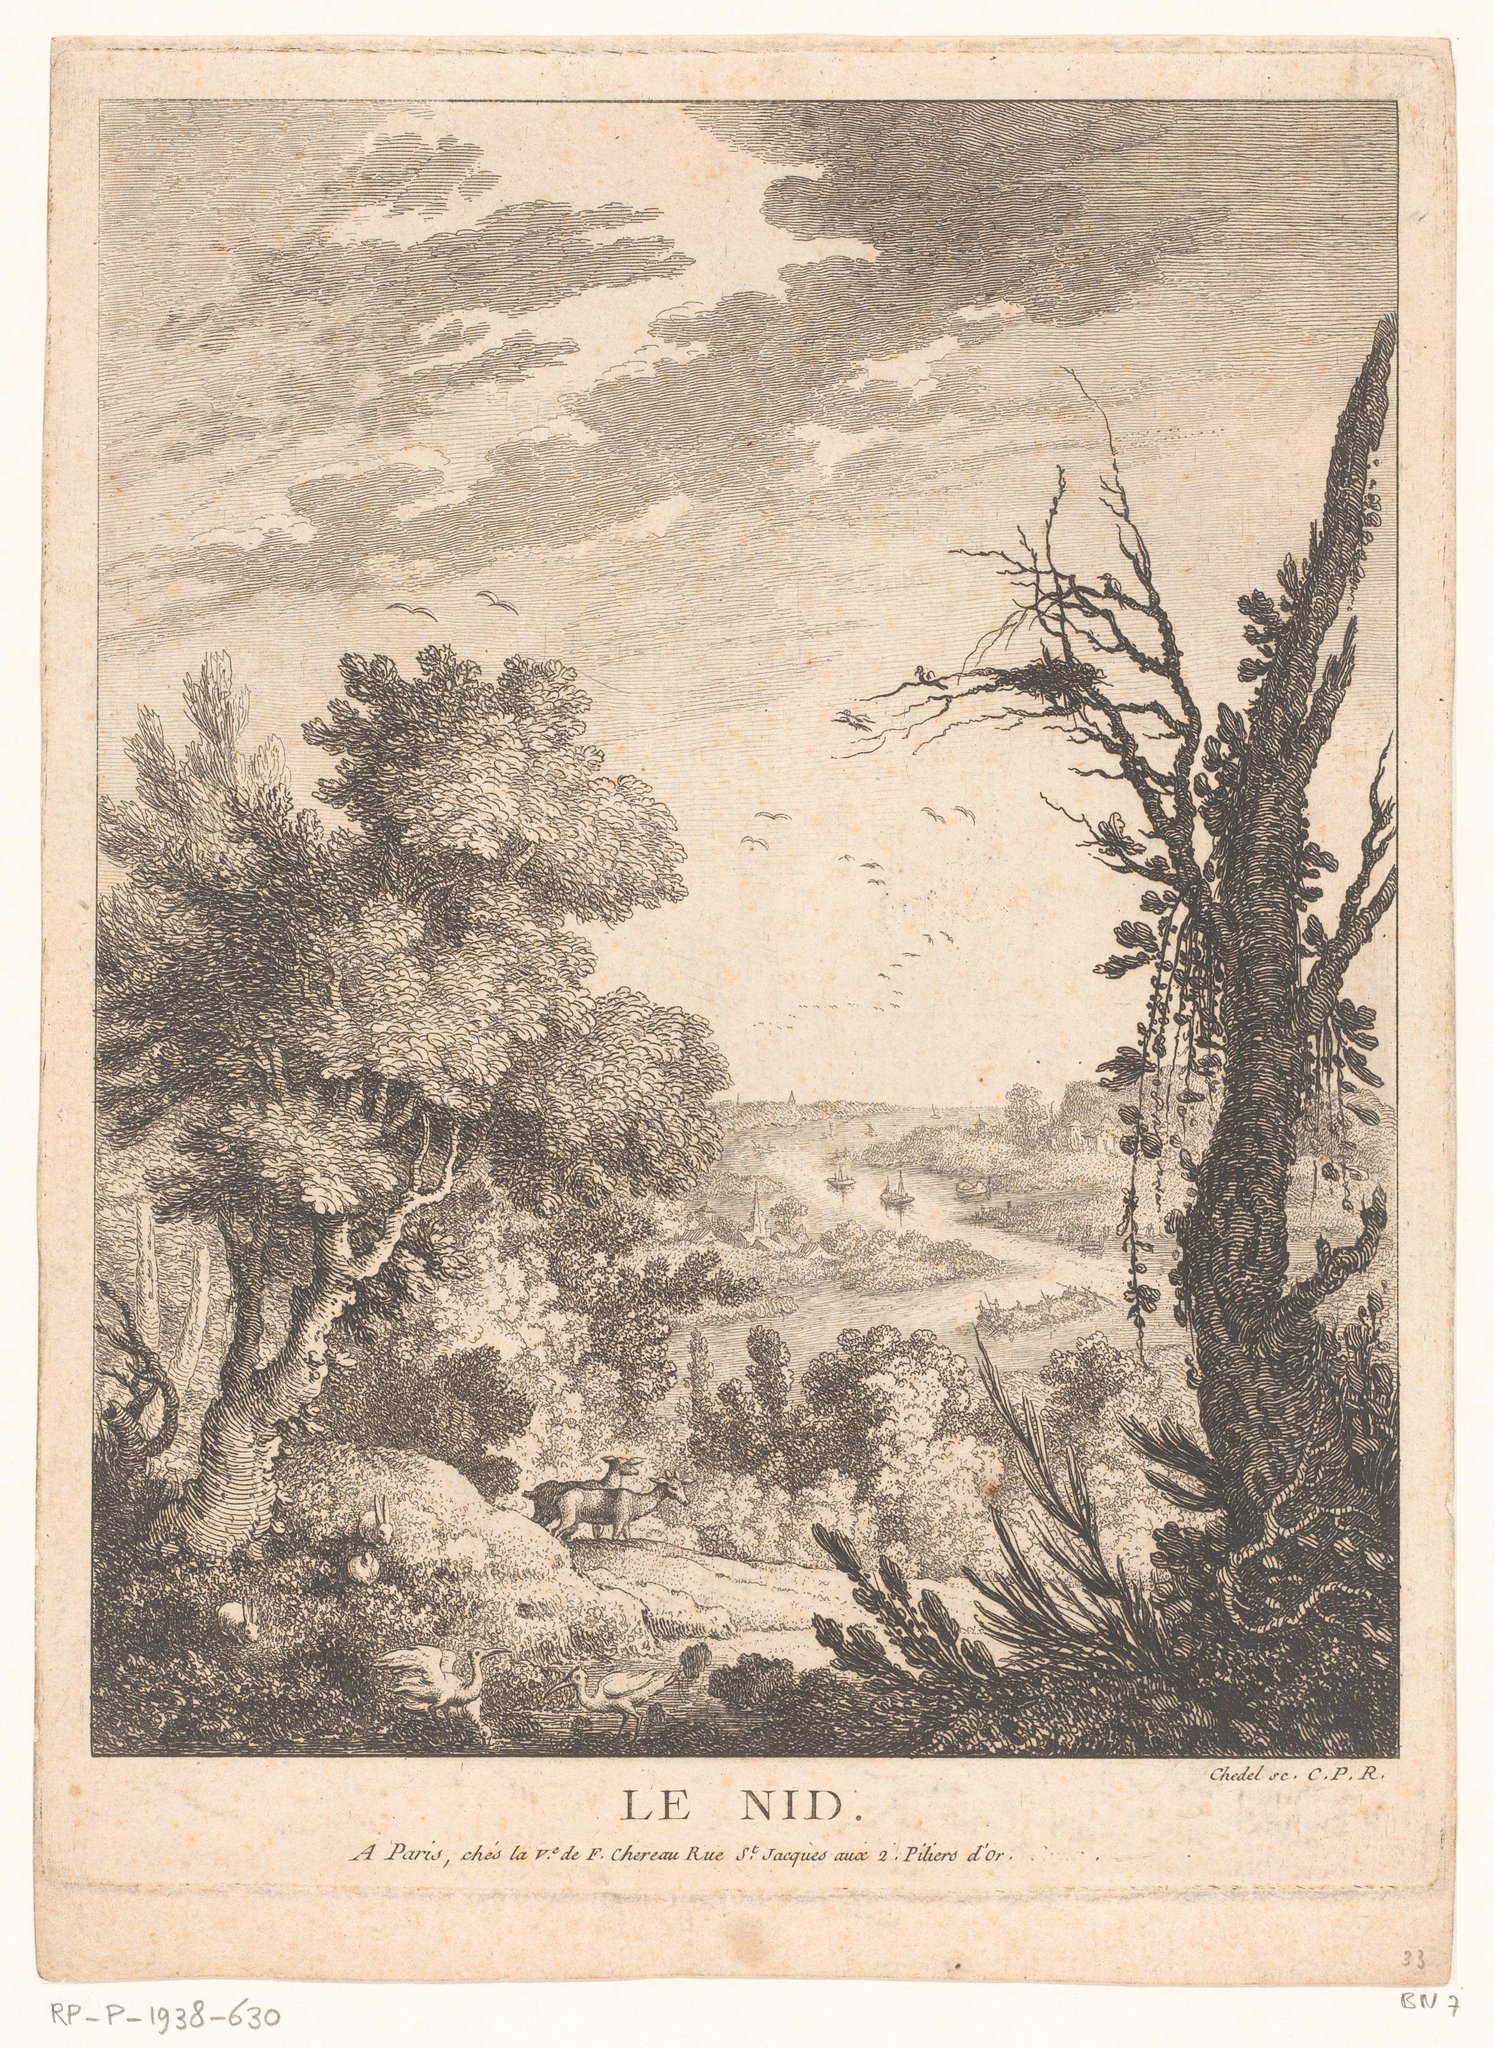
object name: print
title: Le Nid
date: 1753-1782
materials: paper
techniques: etching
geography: paris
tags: hoofed animals: deer, landscapes in the temperate zone, rodents: rabbit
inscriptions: collector's mark: Lugt 2760, inscription: ‘FA Maglin/ 1905’, collector's mark: Lugt 2228